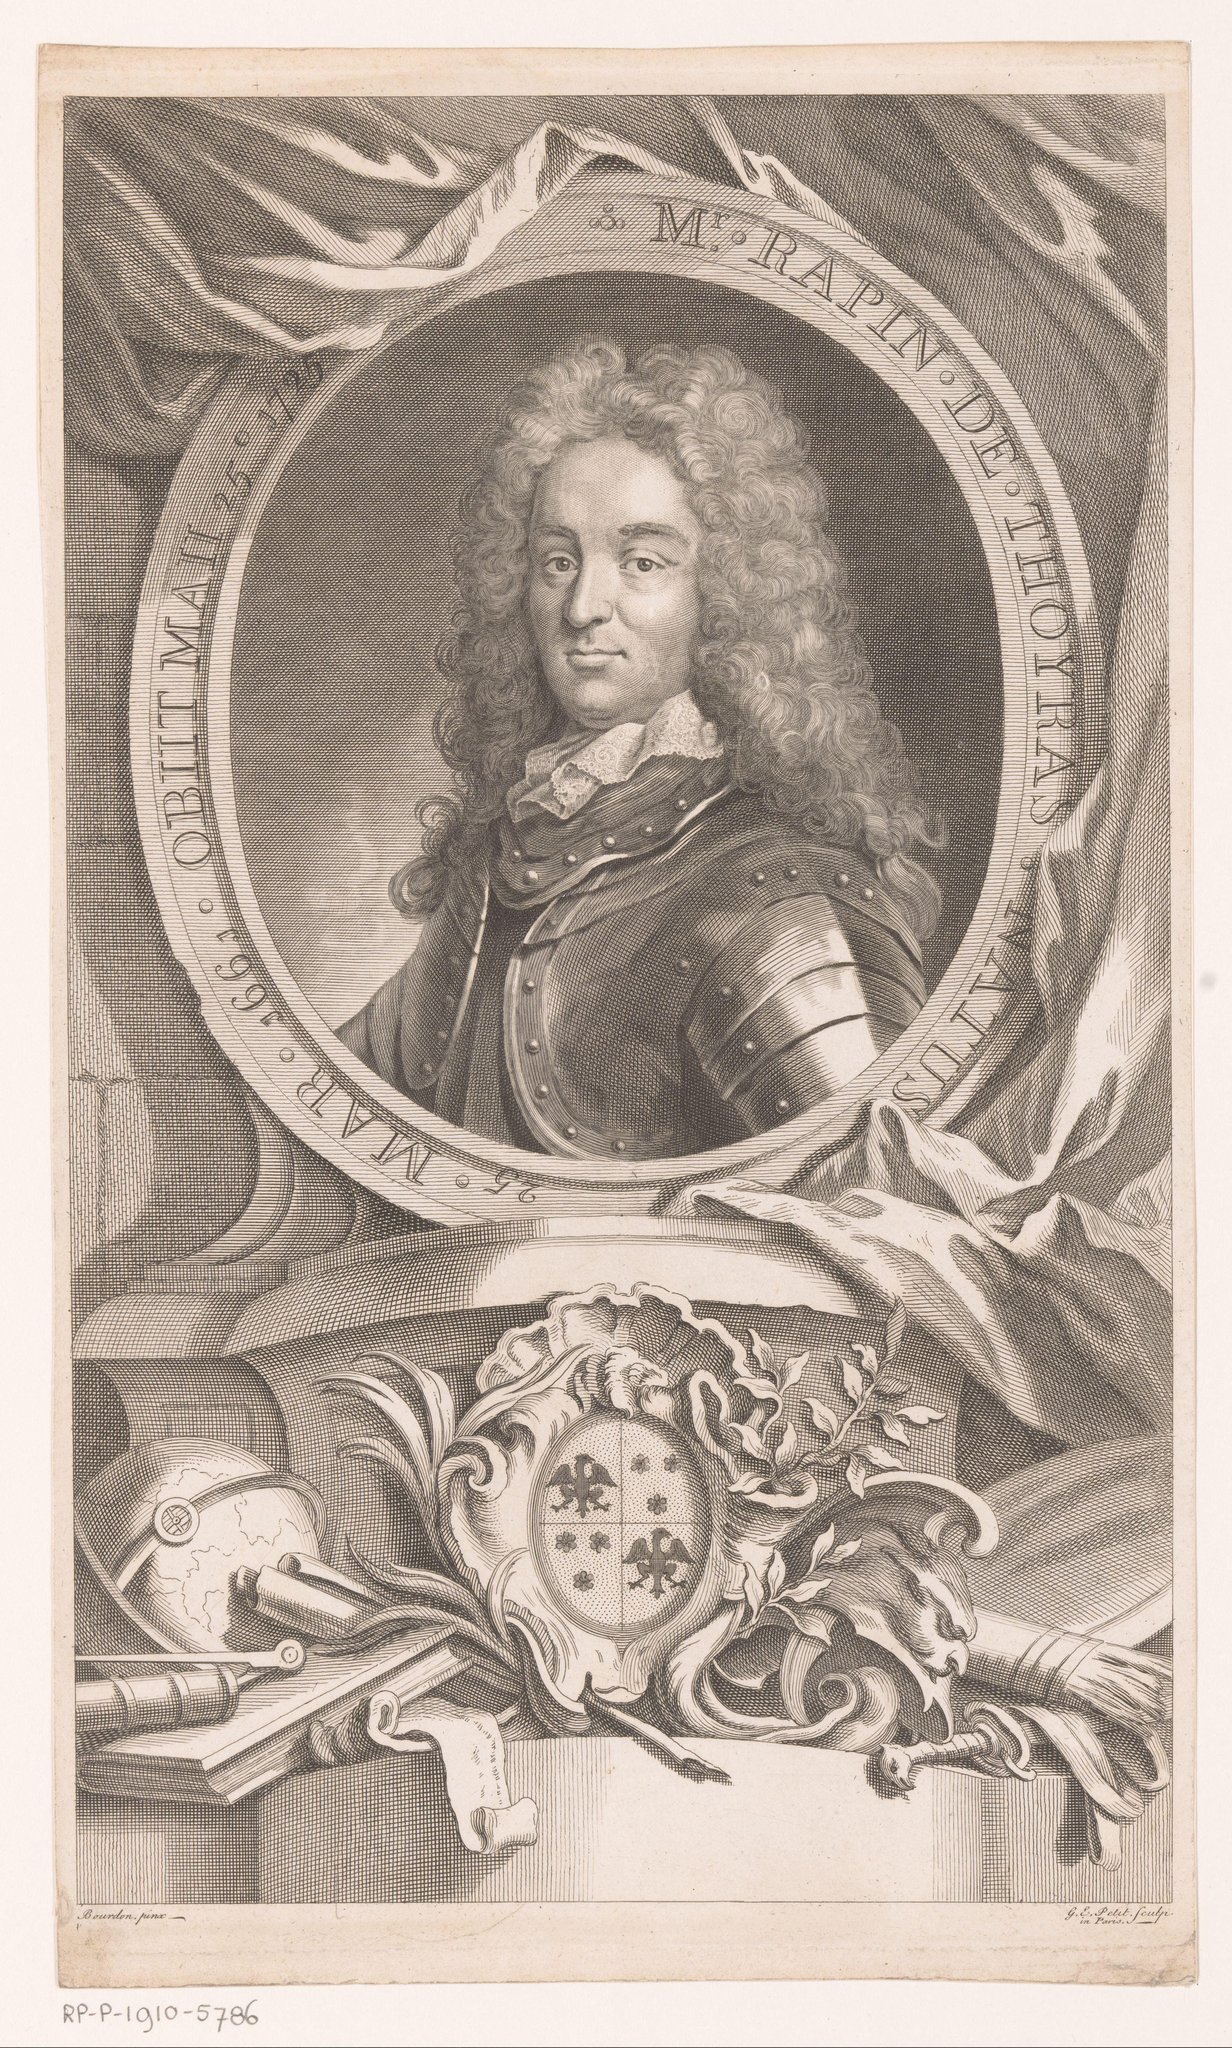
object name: print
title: Portret van Paul de Rapin de Thoyras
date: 1730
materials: paper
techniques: engraving, etching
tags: scholar, philosopher, historical persons, historical disciplines; philology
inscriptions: collector's mark: Lugt 2228